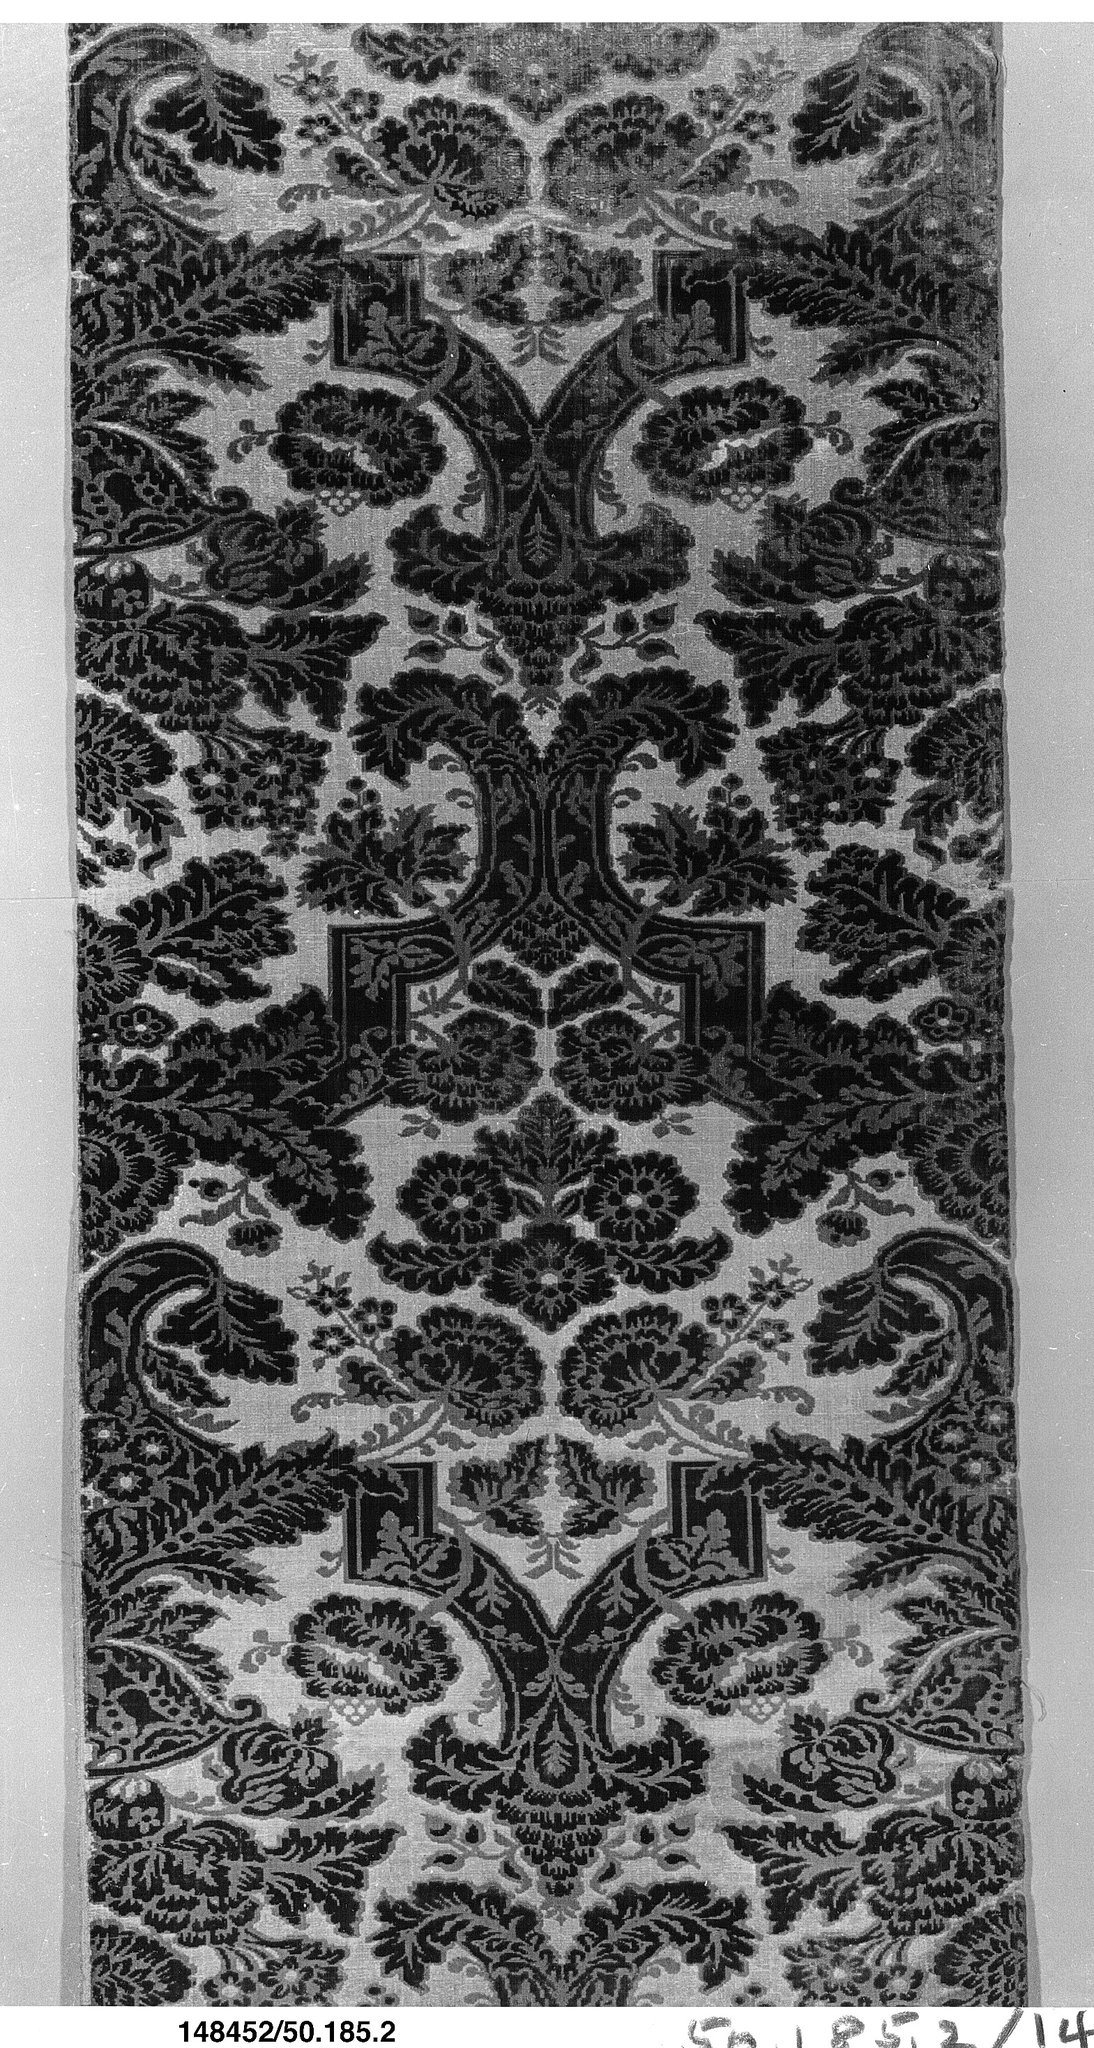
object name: panel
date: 1730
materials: metal thread, silk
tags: flowers,leaves